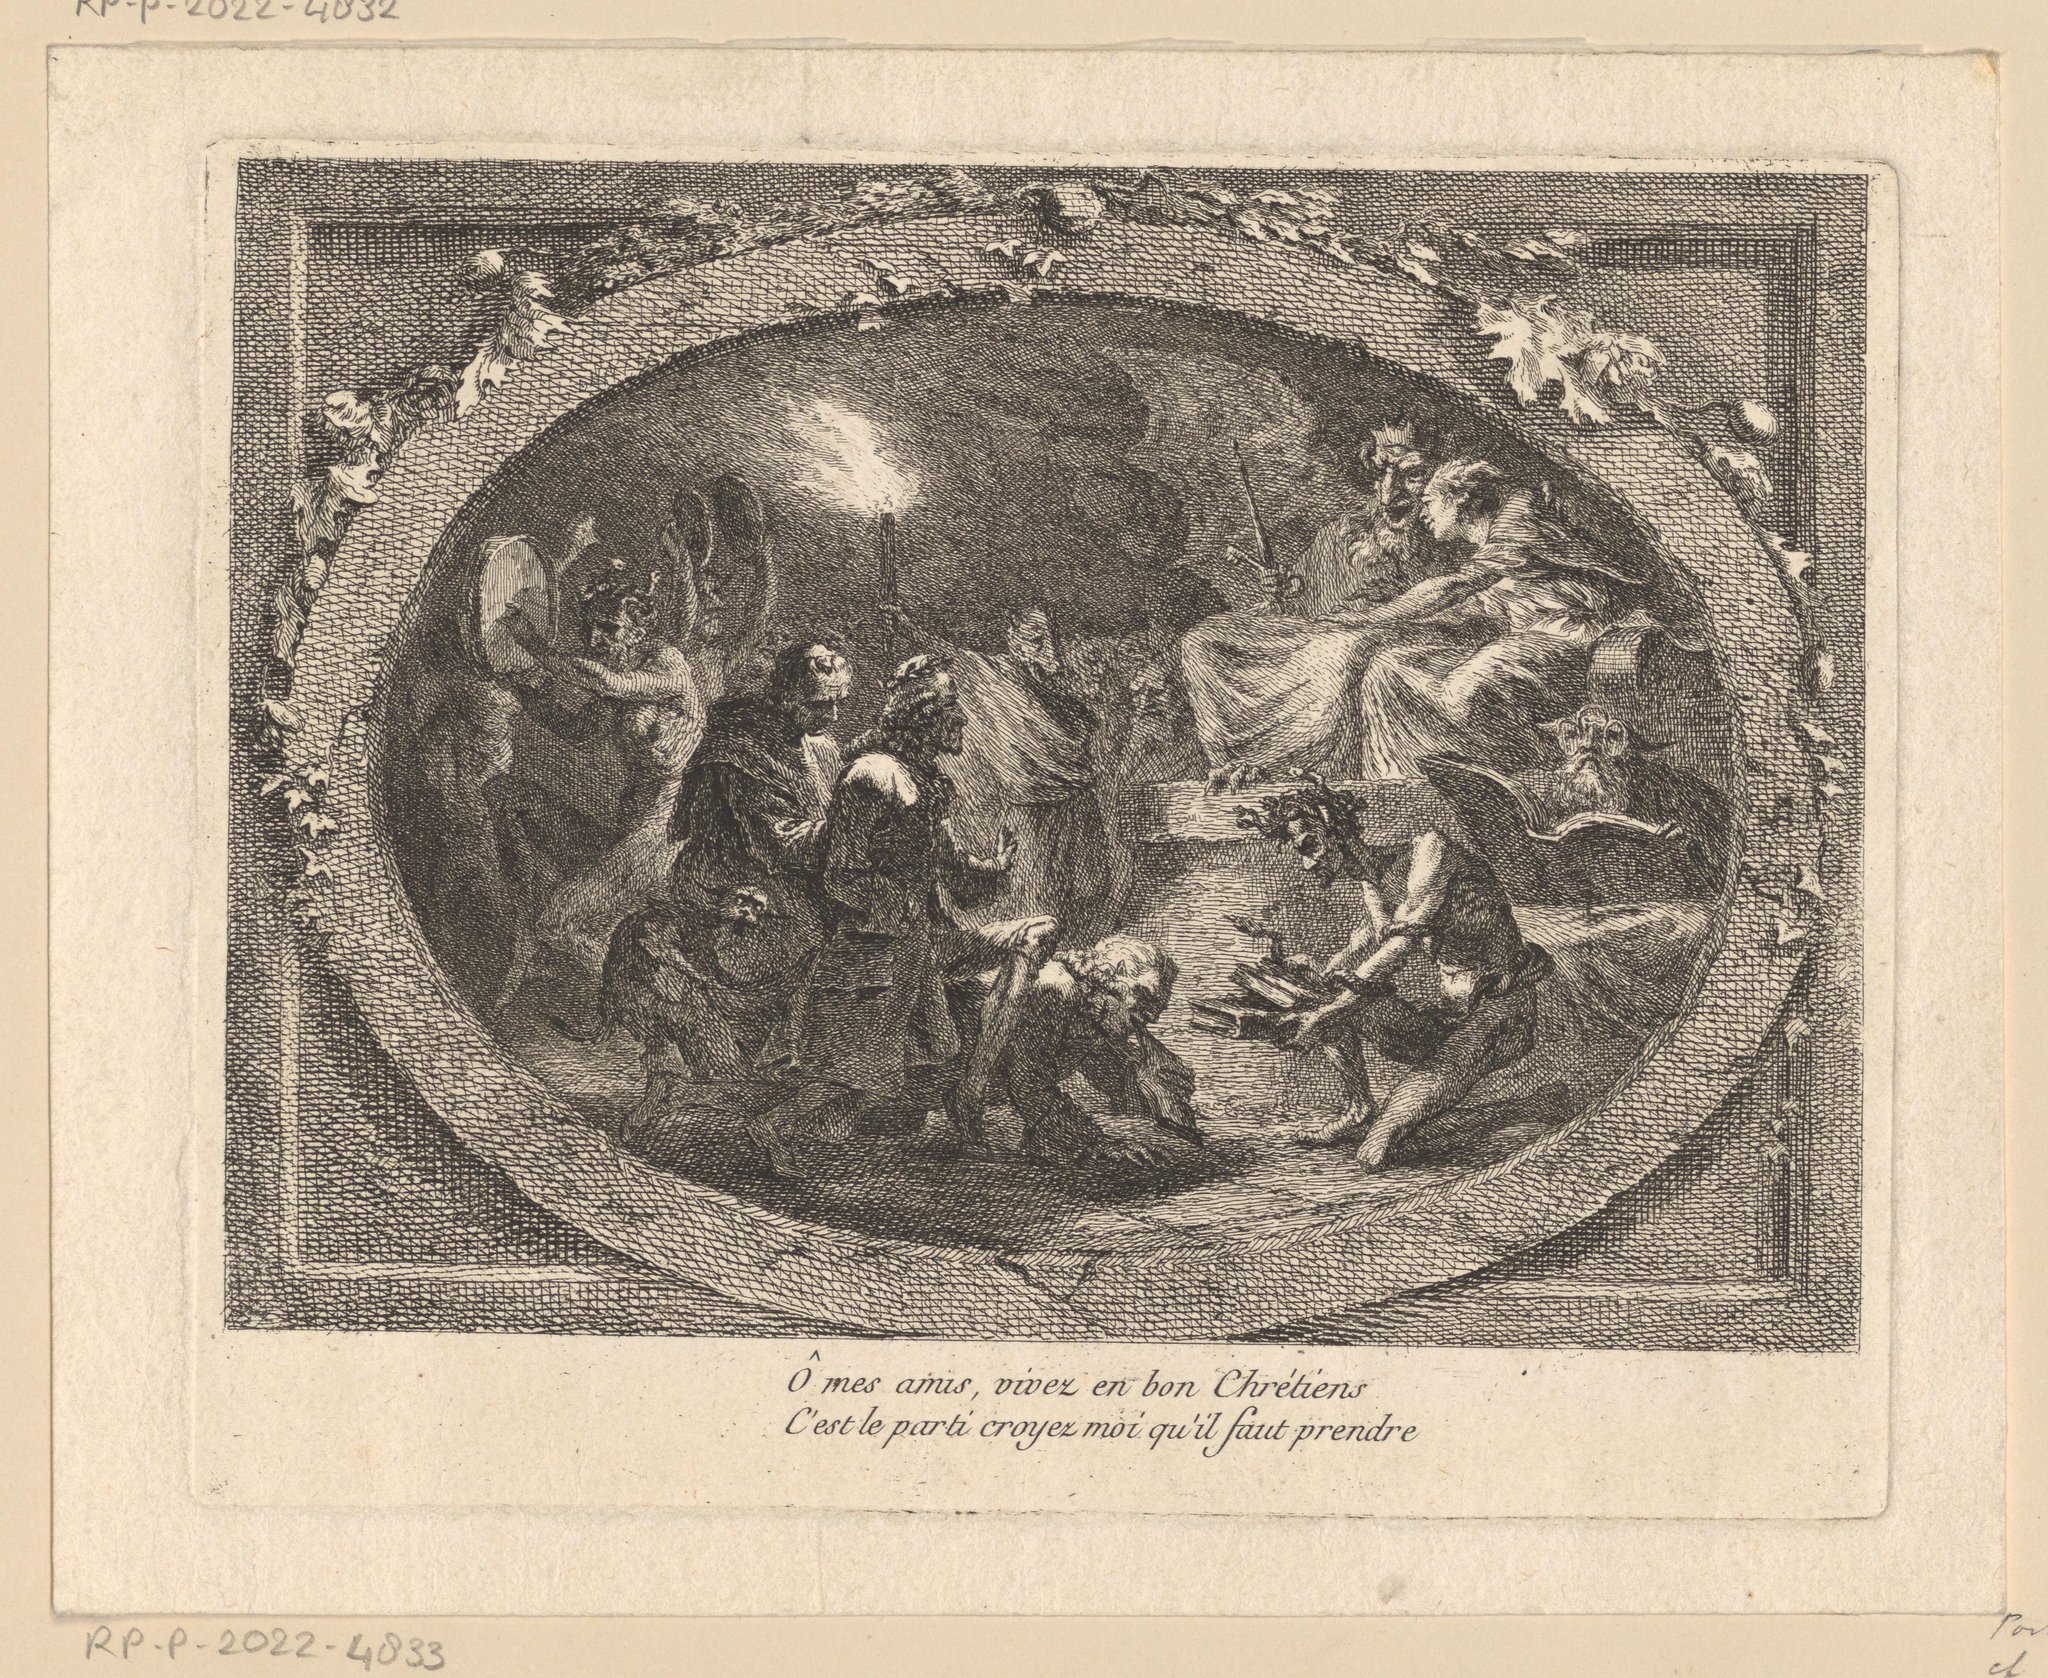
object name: print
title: Voltaire aangekomen in de hel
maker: Anonymous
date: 1778-1800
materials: paper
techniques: etching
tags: paris, voltaire, hell and purgatory, historical persons, devil(s) and demons, portrait of a writer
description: Met tweeregelig onderschrift in het Frans.